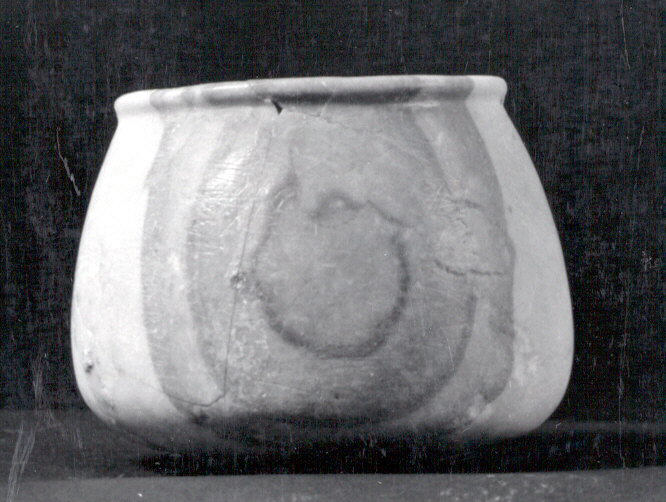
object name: jar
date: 7333-7001 BCE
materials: alabaster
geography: syria